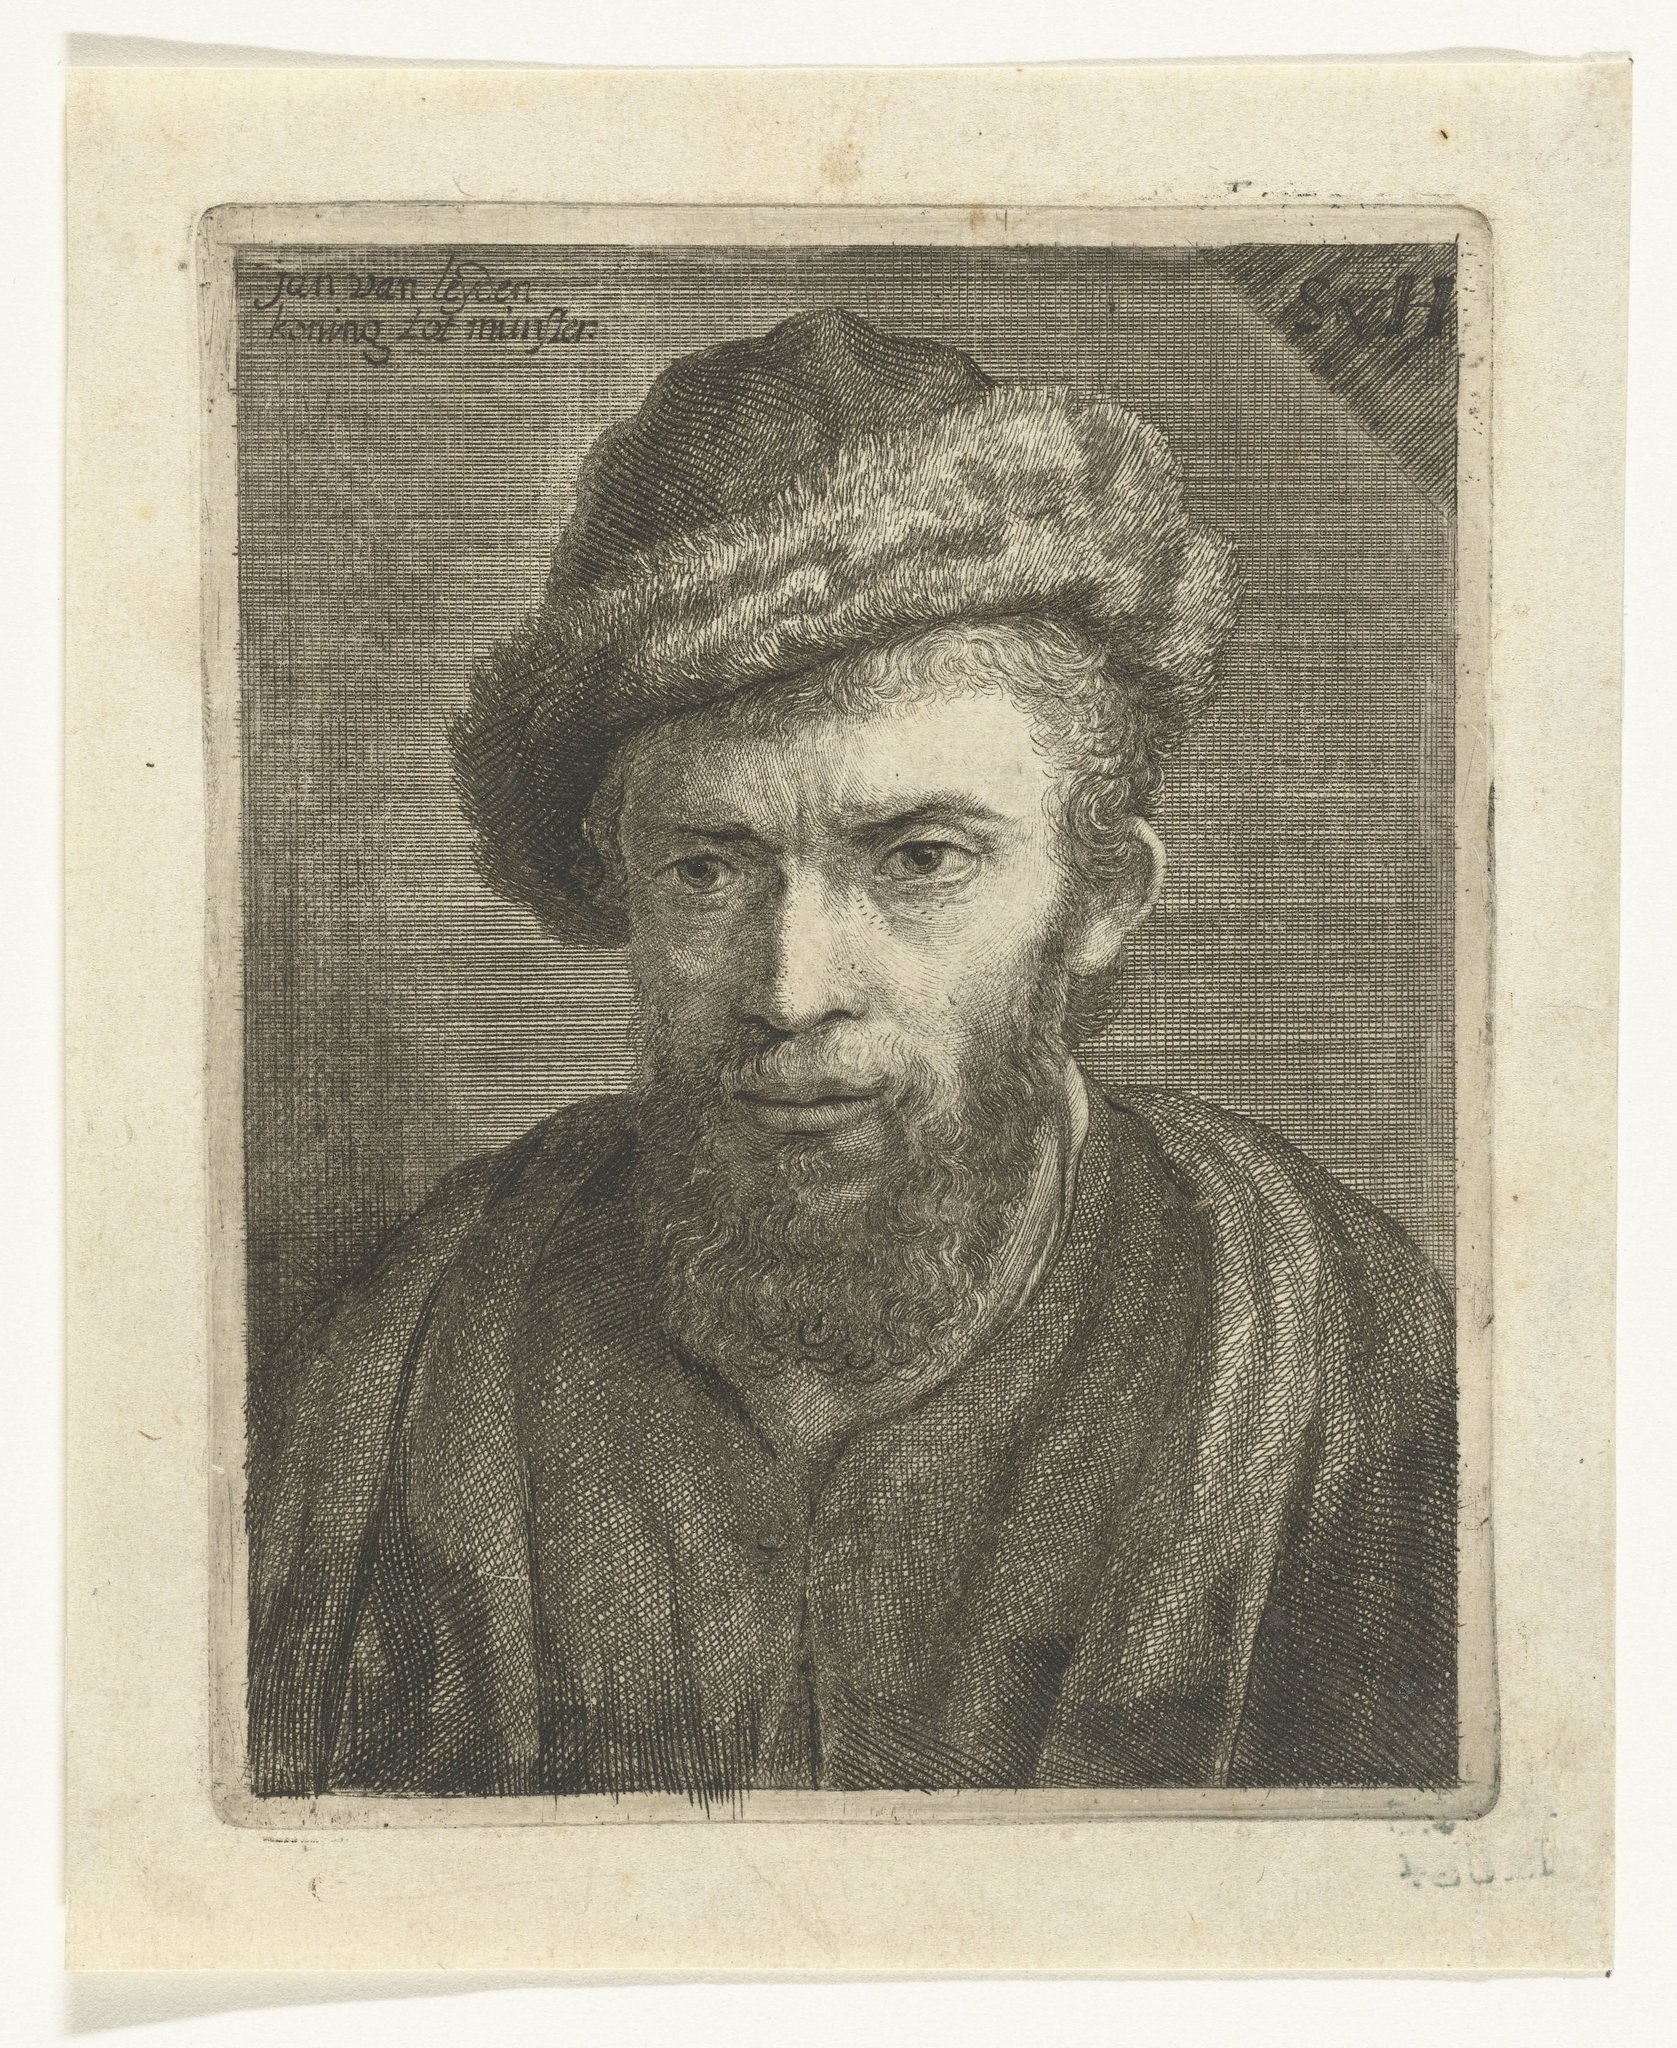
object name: print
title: Jan van Leyden koning tot münster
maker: samuel van hoogstraten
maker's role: draughtsman, painter, print maker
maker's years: 1627-1678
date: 1648-1678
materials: paper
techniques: engraving, etching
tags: leiden, head-gear (with name)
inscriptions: collector's mark: Lugt 2165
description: Buste van een man met baard en bontmuts op. De titel suggereert dat het Jan van Leyden, koning van Münster moet voorstellen.